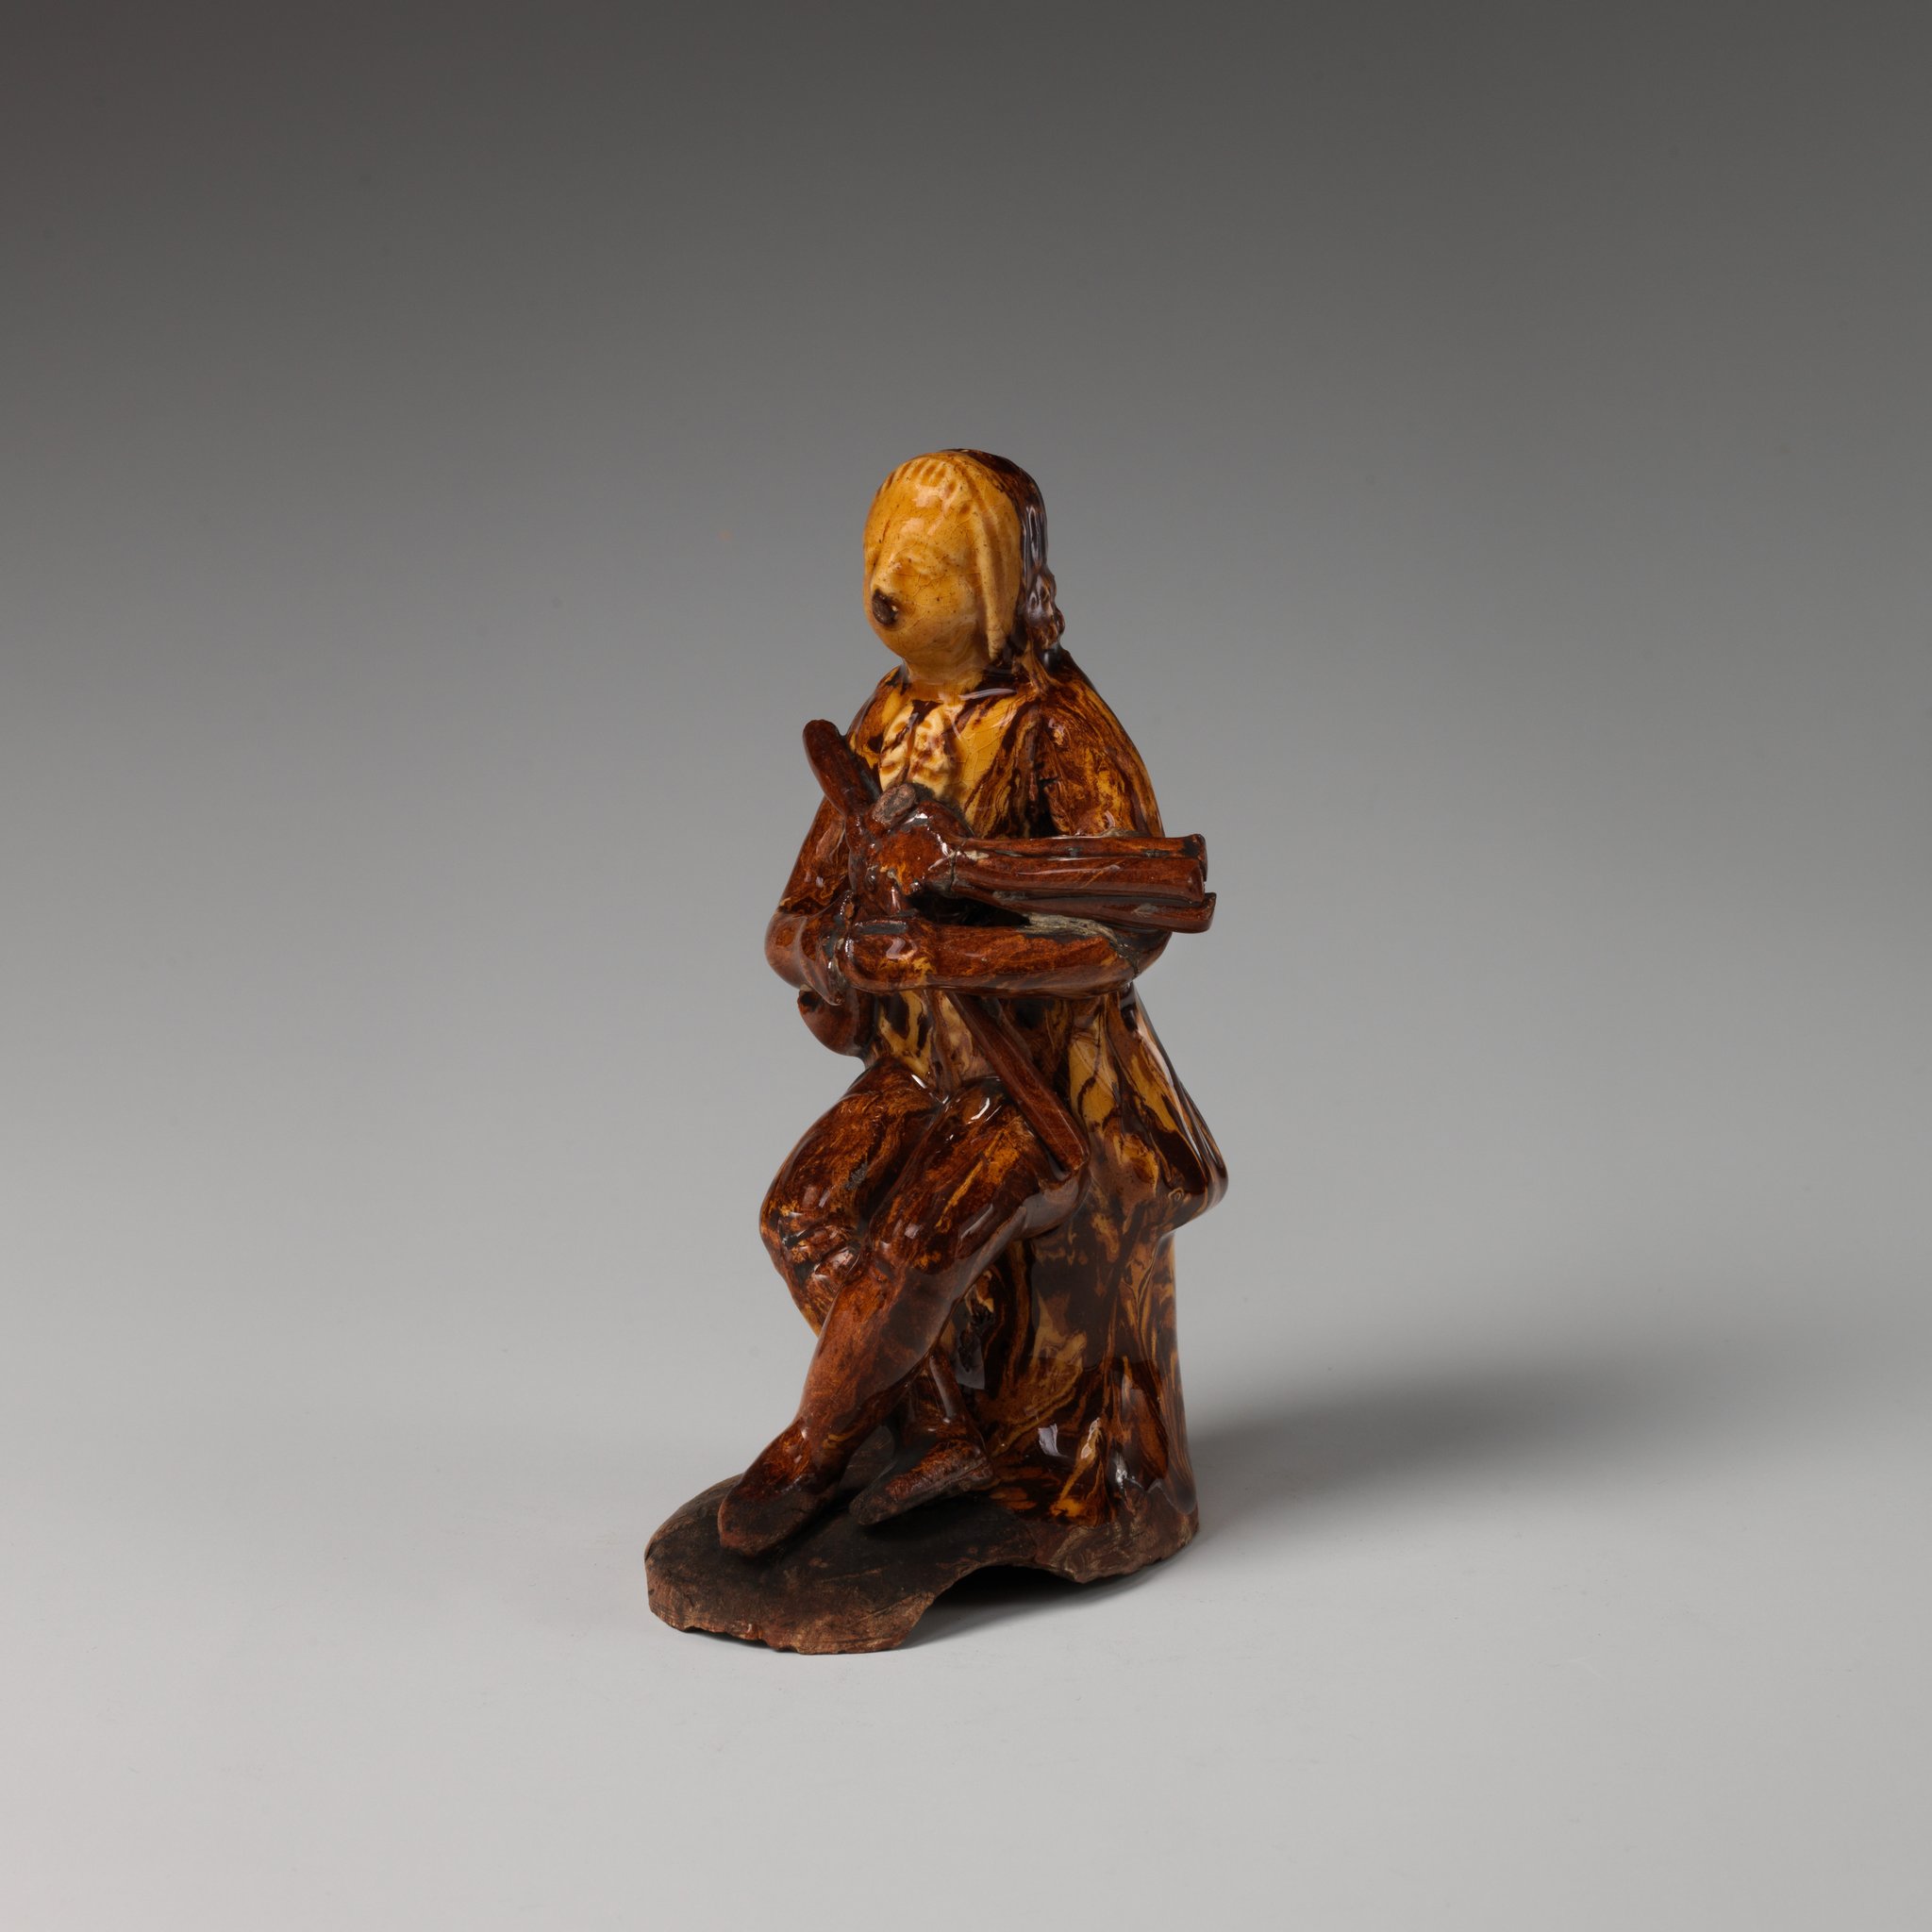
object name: figure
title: Bagpiper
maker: john astbury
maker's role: maker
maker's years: 1688-1743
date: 1745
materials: earthenware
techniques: glazing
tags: men,bagpipes